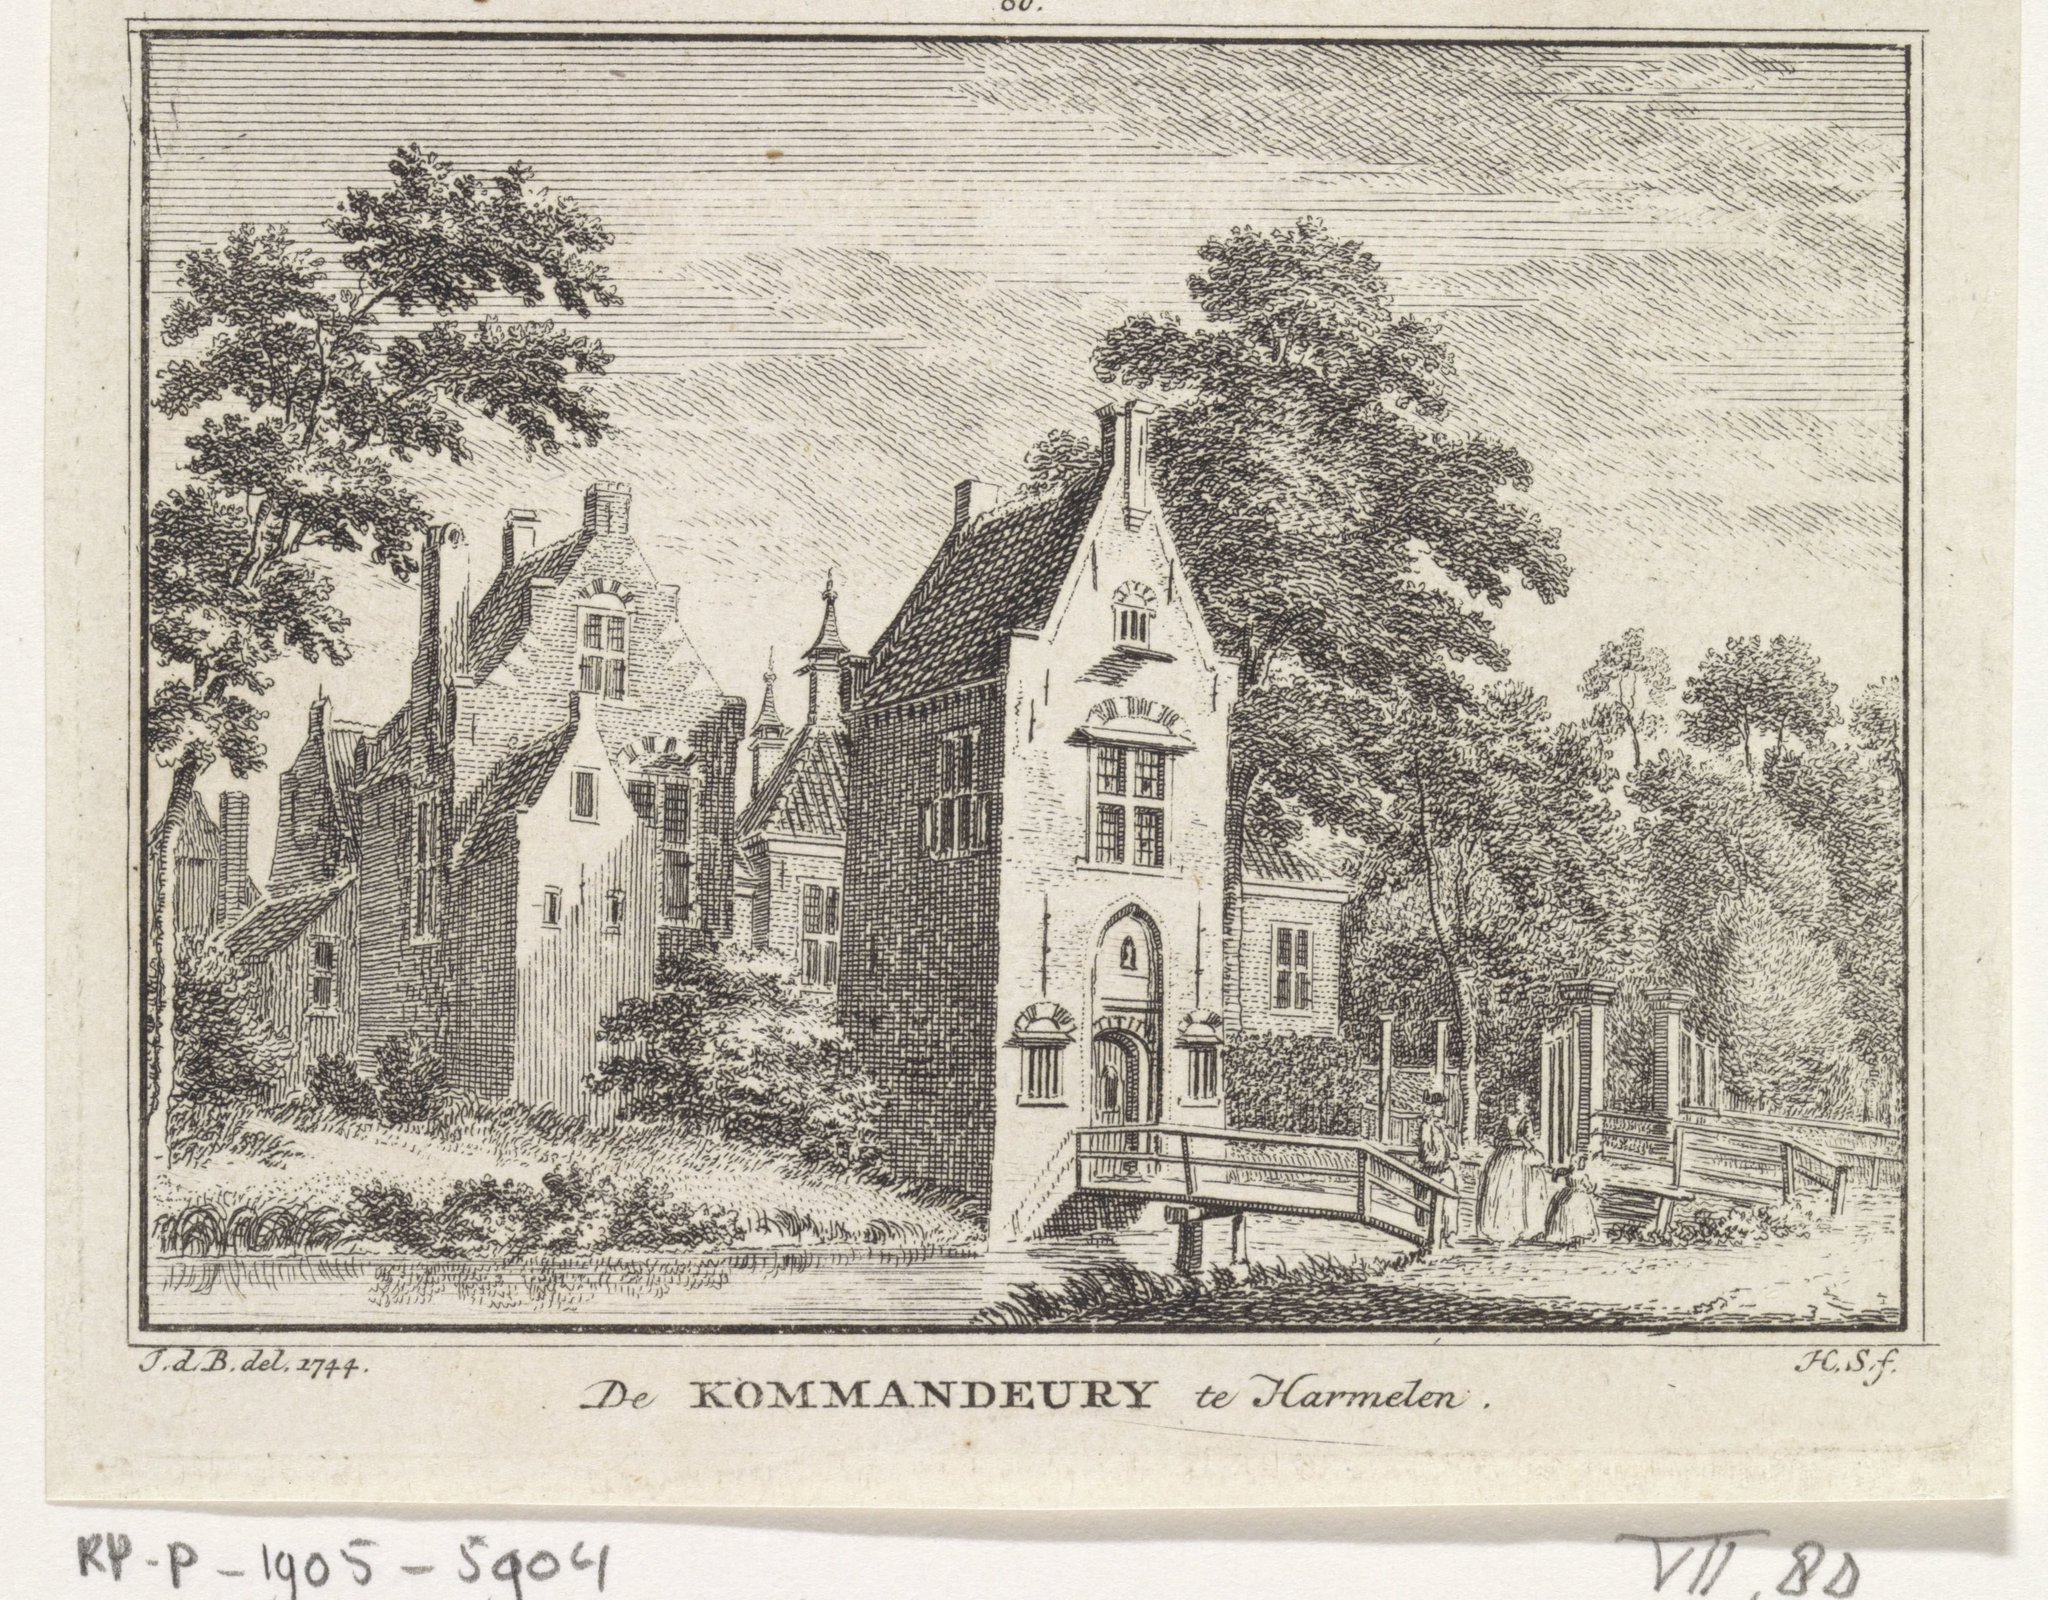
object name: print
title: De Kommandeury te Harmelen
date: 1773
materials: paper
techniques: etching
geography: haarlem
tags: castle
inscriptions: collector's mark: Lugt 2228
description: Prent gebruikt in: Het verheerlykt Nederland of kabinet van hedendaagsche gezigten van steden, dorpen, sloten ... en andere voornaame stad- en landgebouwen, in en omtrent alle de byzondere Vereenigde Nederlandsche Provinciën : gedurende de laatste jaaren door vermaarden kunsttekenaren na het leven getekent en ... in 't koper gebragt ... dienende tot opheldering der beschryvinge van den Tegenwoordigen Staat der Vereenigde Nederlanden. Deel VII, 1773. Amsterdam: Isaac Tirion, 1745-1774.